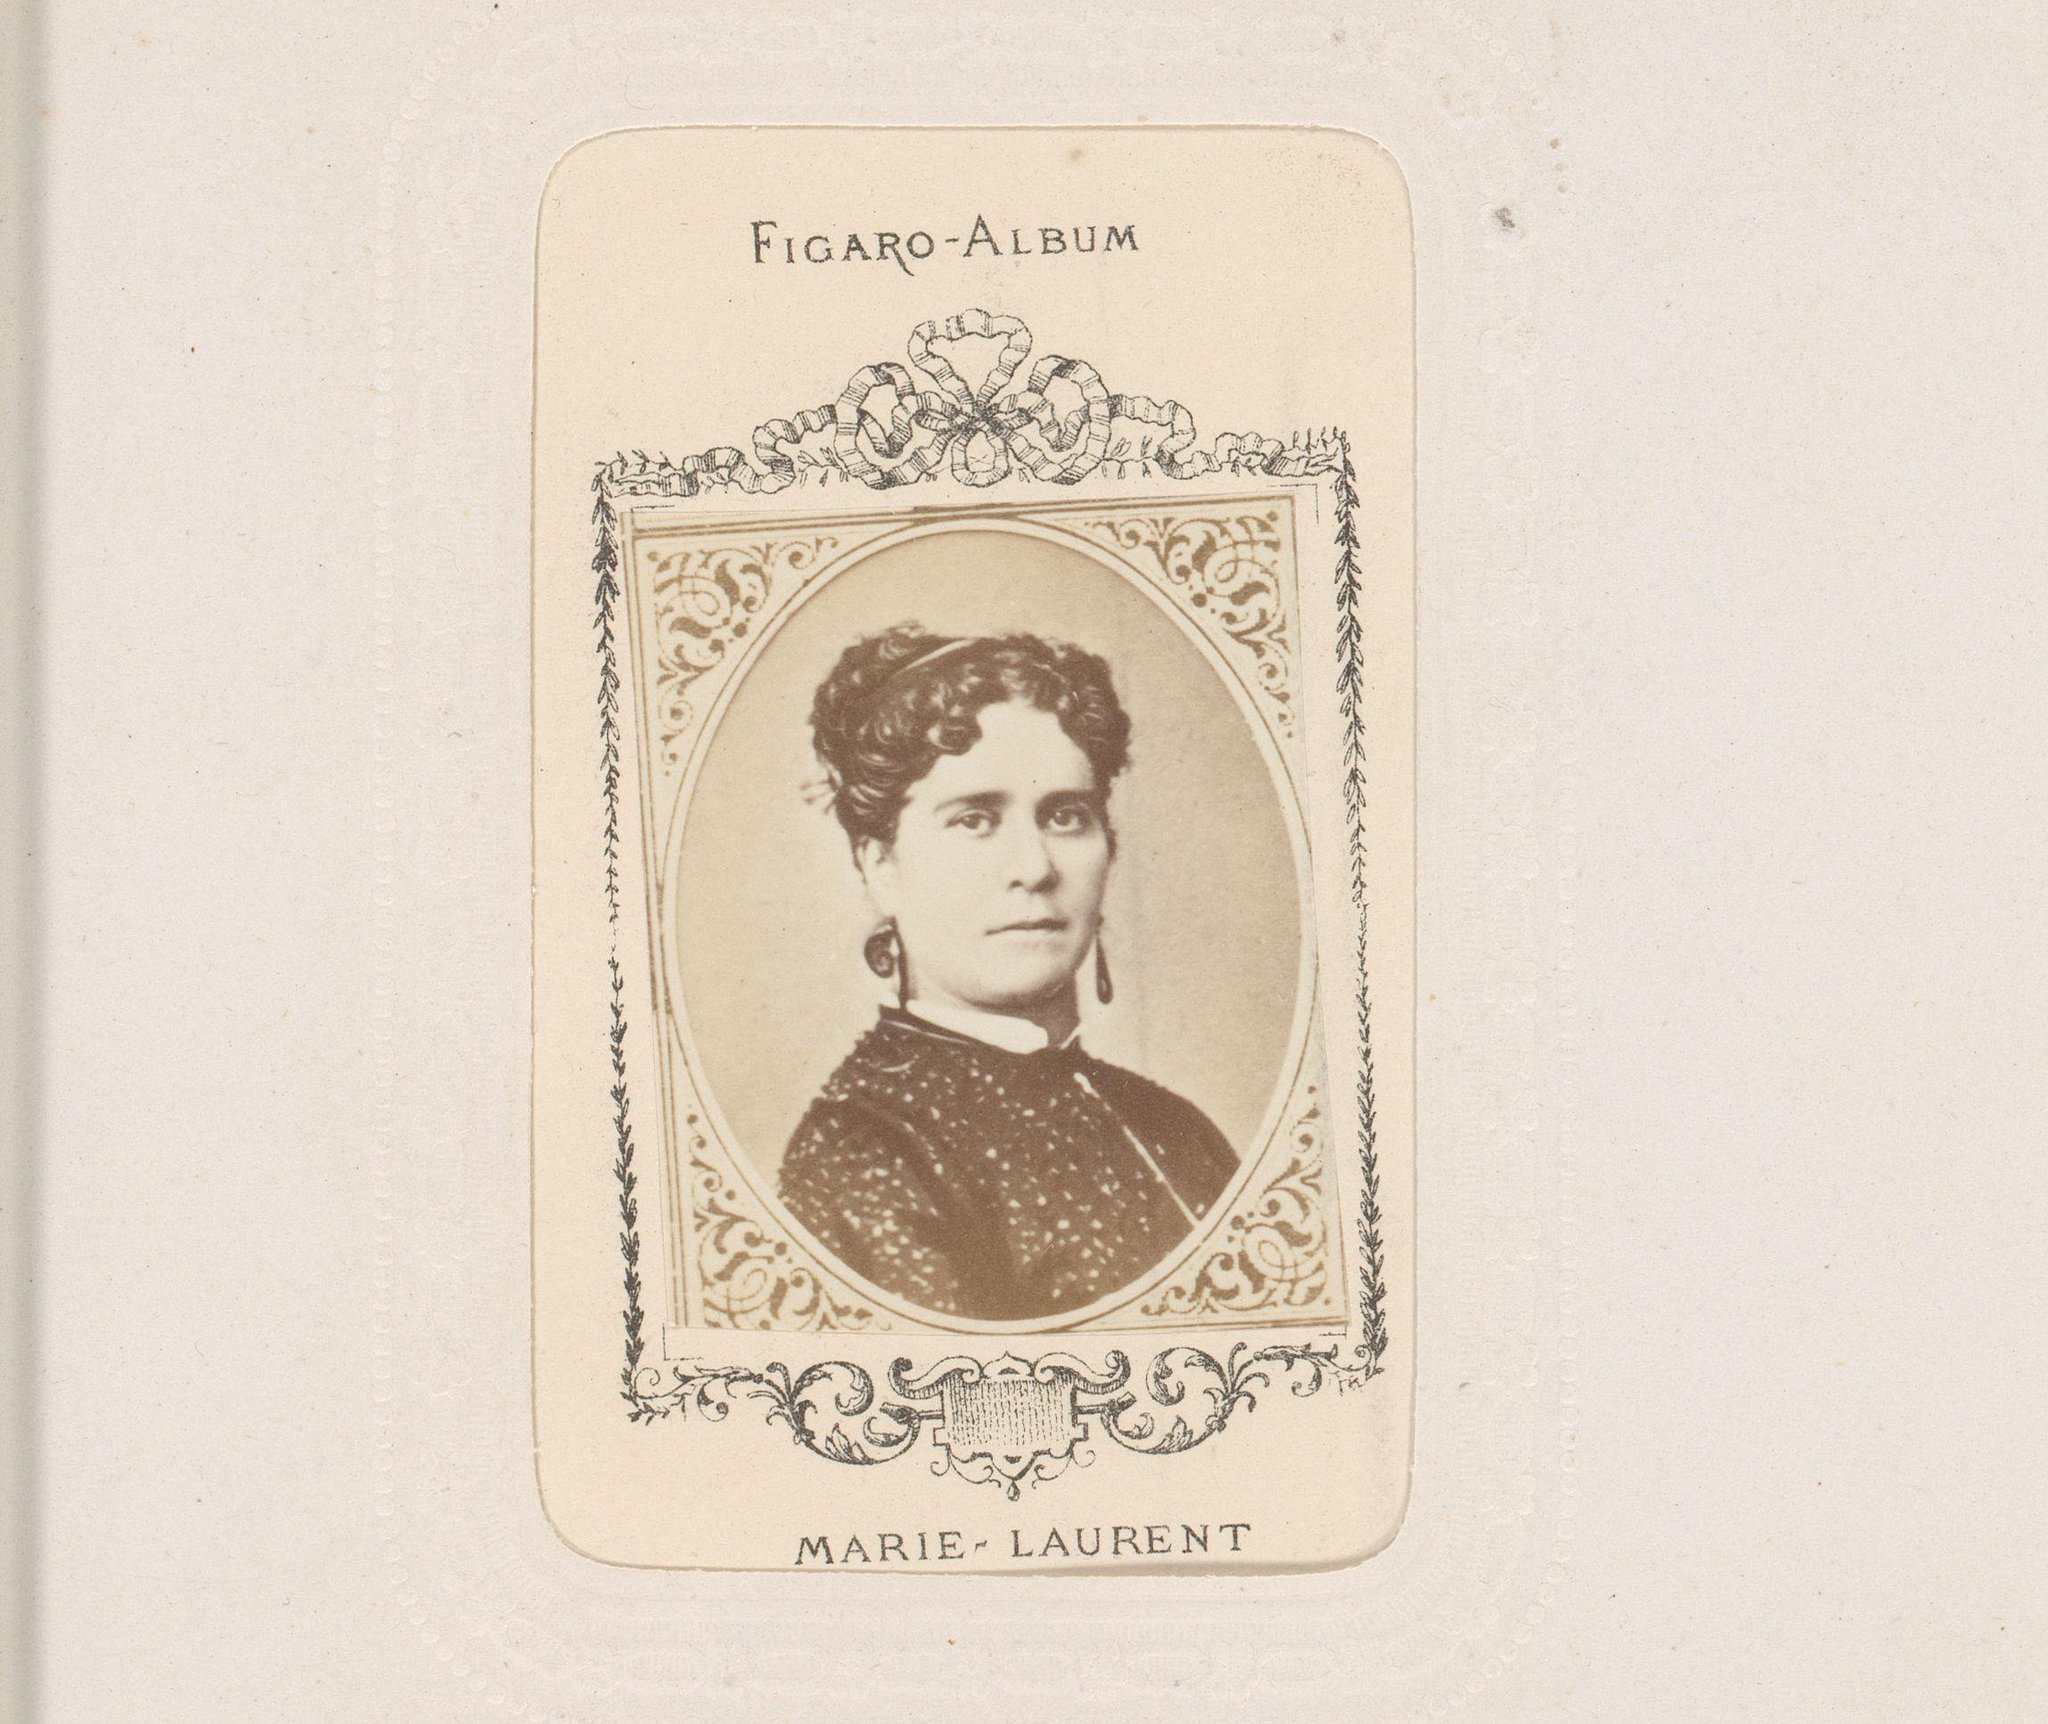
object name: photograph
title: Fotoreproductie van een portret van Marie Laurent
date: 1860-1900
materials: cardboard, photographic support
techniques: albumen print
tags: historical persons - bb - woman, portrait of actor, actress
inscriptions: inscription: ‘Figaro-Album/ Marie-Laurent/ d'après Liébert Phot.’